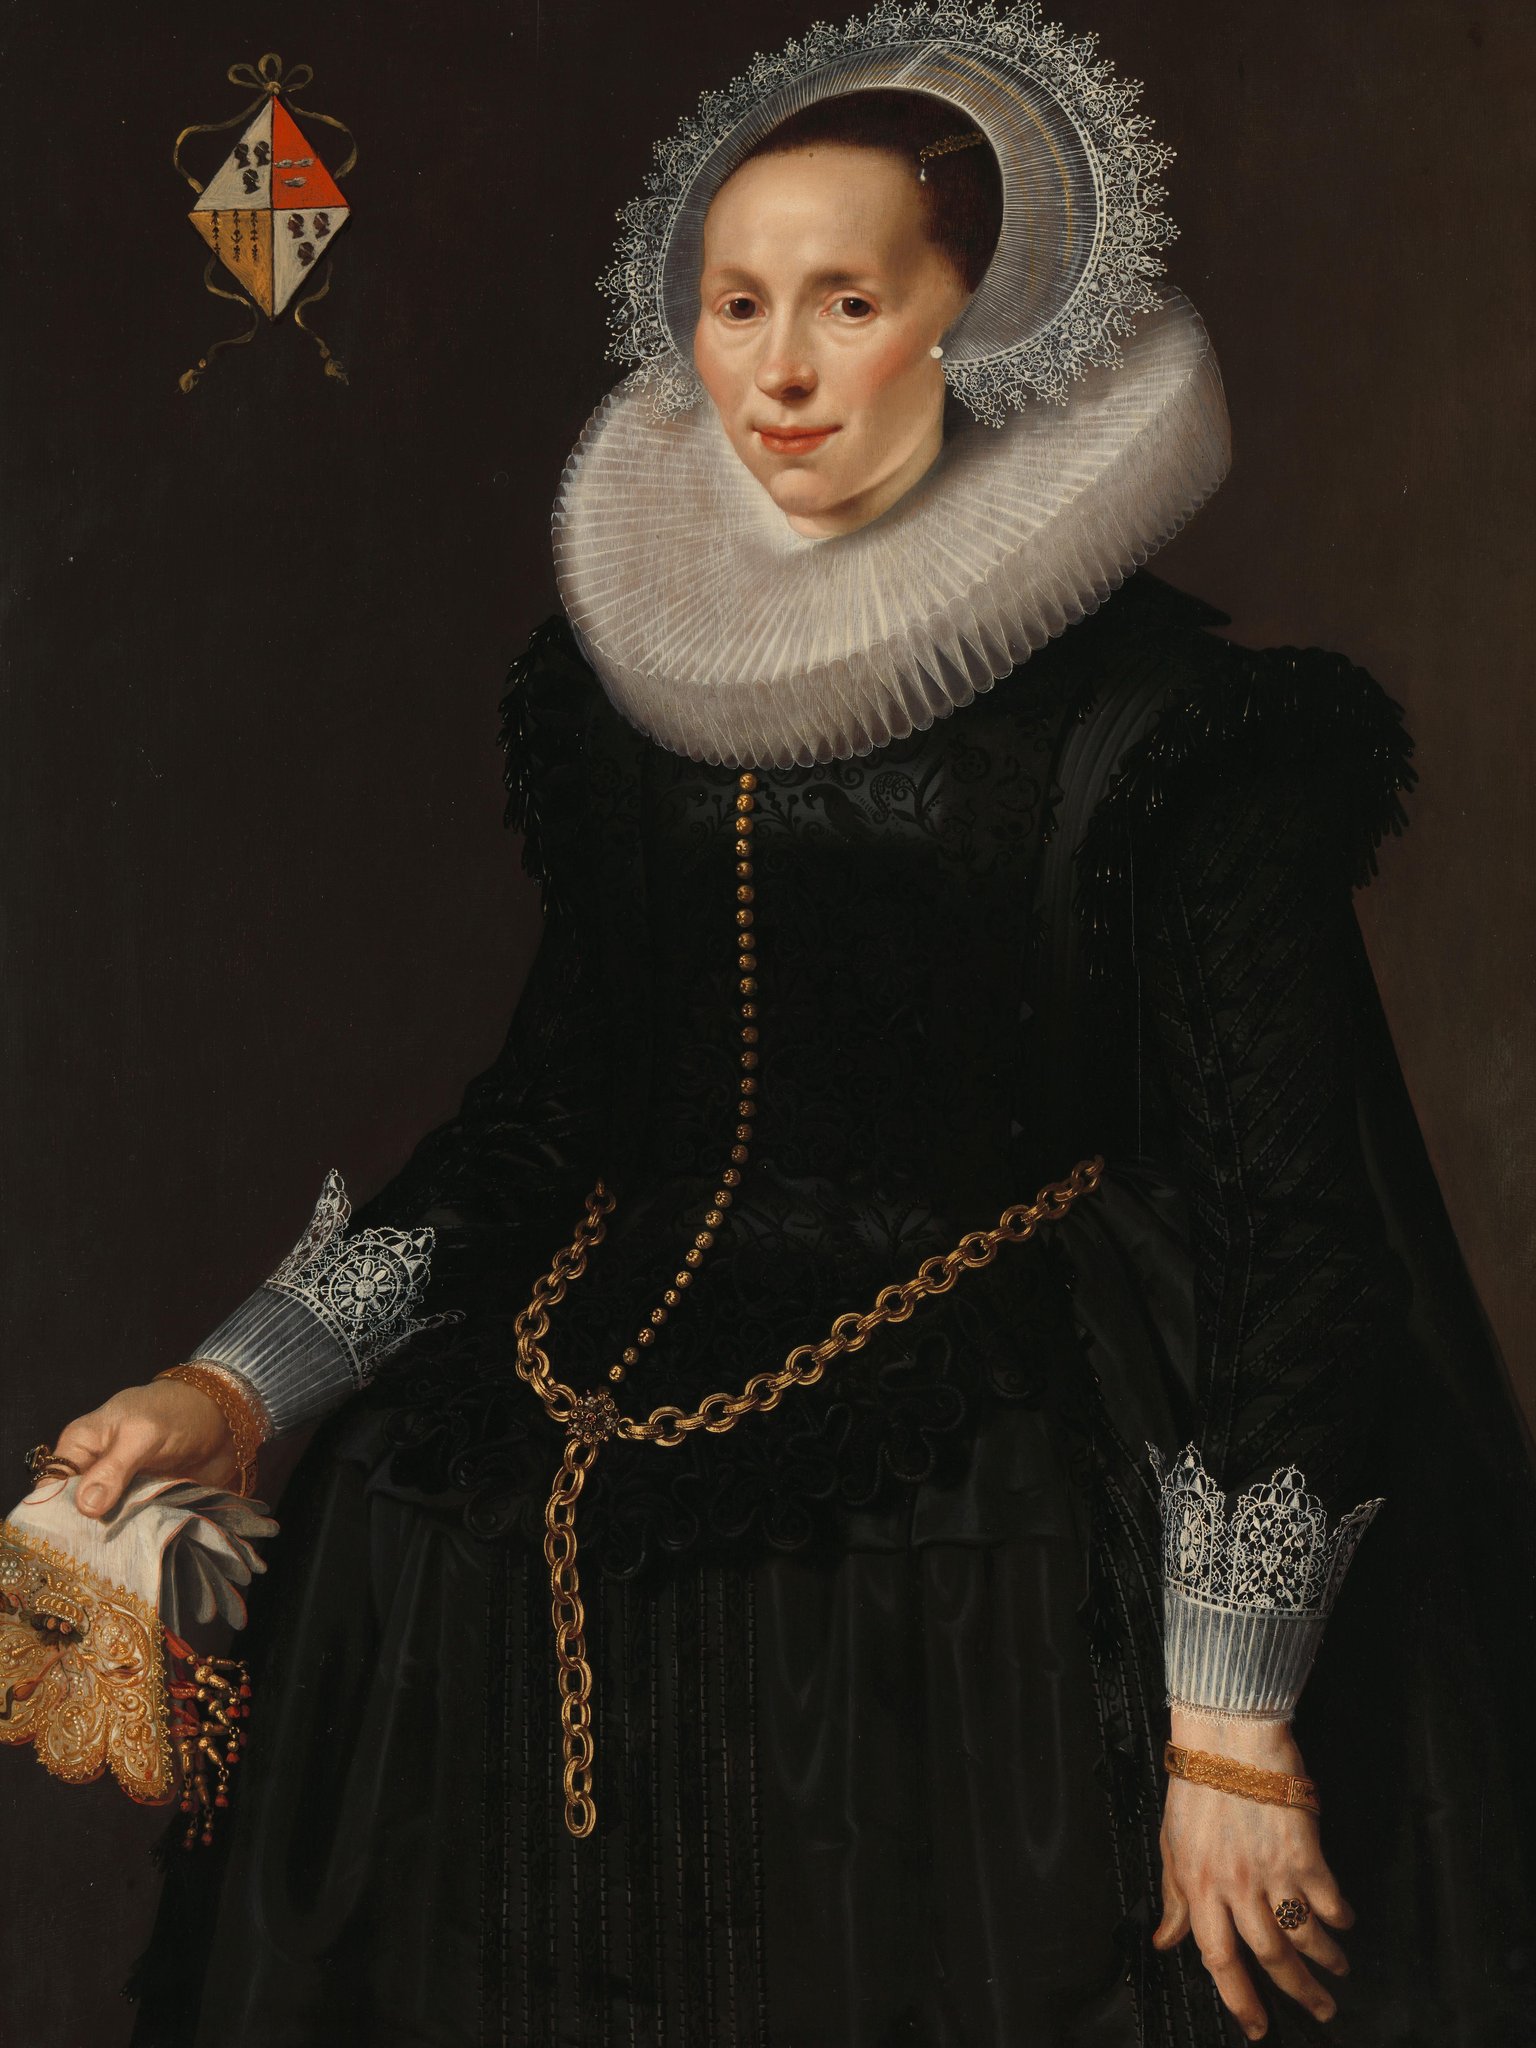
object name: painting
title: Portrait of Johanna le Maire (c. 1601-60)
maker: nicolaes eliasz pickenoy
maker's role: painter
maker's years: 1588-1656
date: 1622-1629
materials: oil, paint, panel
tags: historical persons - bb - woman, gloves, mittens, etc.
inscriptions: coat of arms, top left: quartered, 1 and 4: three black Moor’s heads on a silver field, 2: three gold boar’s heads on a red field, 3: three rows of black ermine tails on a gold field, date, top right: ‘162[.]’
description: Nicolaes Eliasz, named Pickenoy (1588 - 1650/56). Johanna Le Maire, wife of Pieter van Son, 1622. Purchase made possible by the SponsorBingo Lottery.